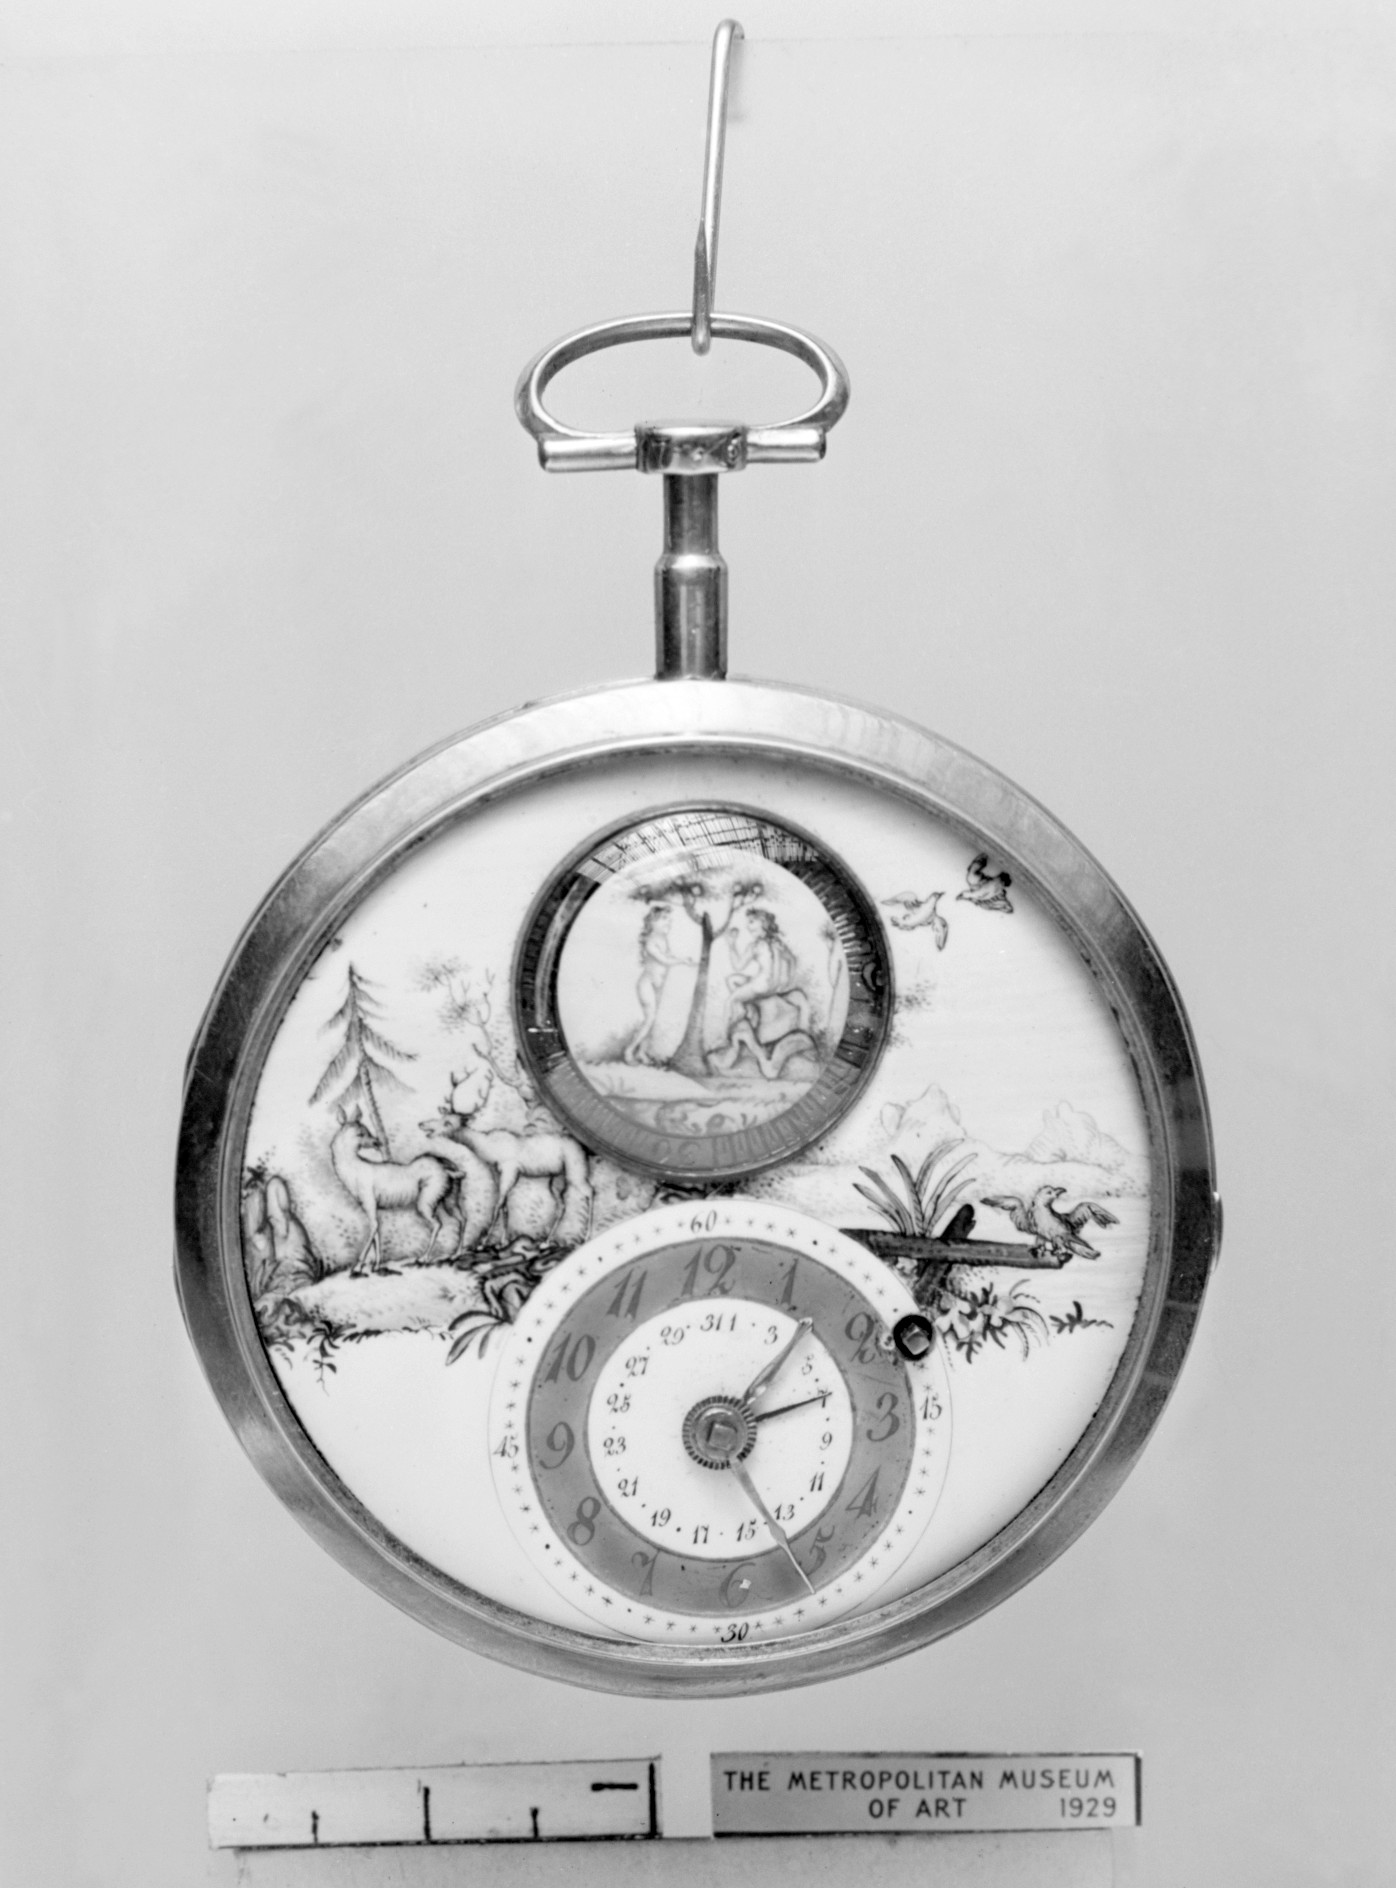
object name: watch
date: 1767-1800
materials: enamel, gold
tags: birds,female nudes